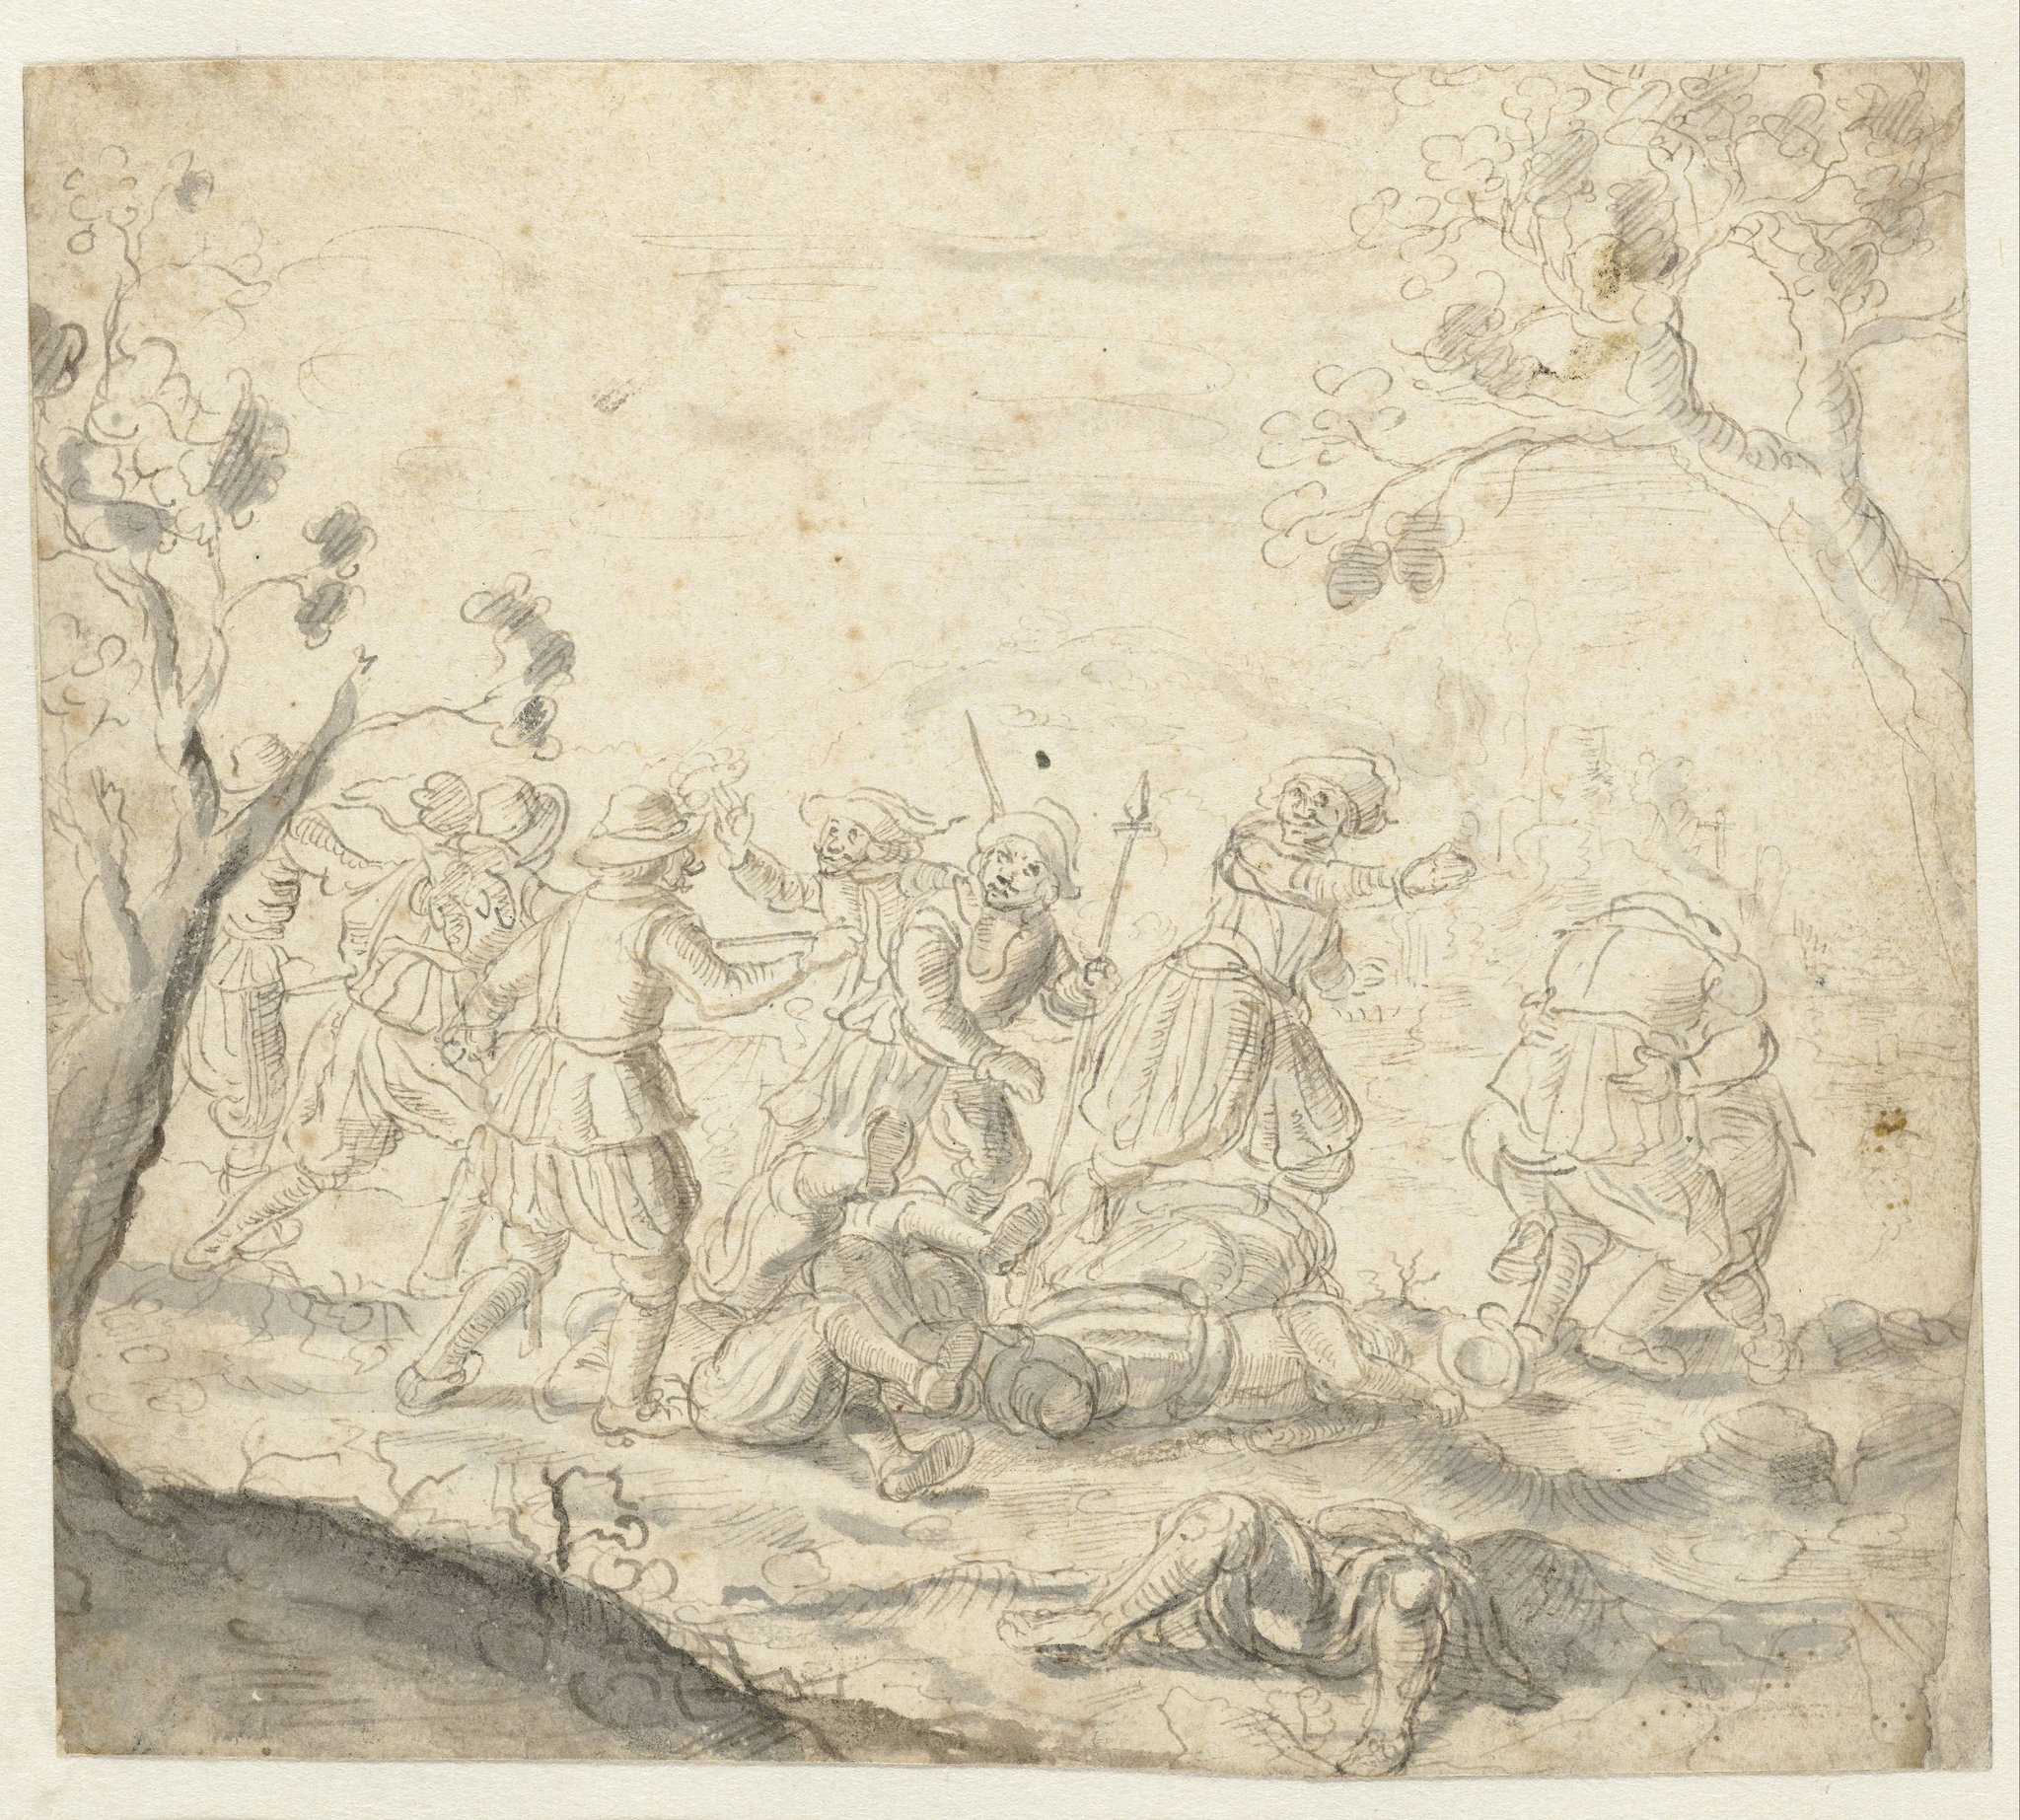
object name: drawing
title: Strijdende infanteristen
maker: Anonymous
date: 1600-1649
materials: ink, paper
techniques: brush, pen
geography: northern netherlands